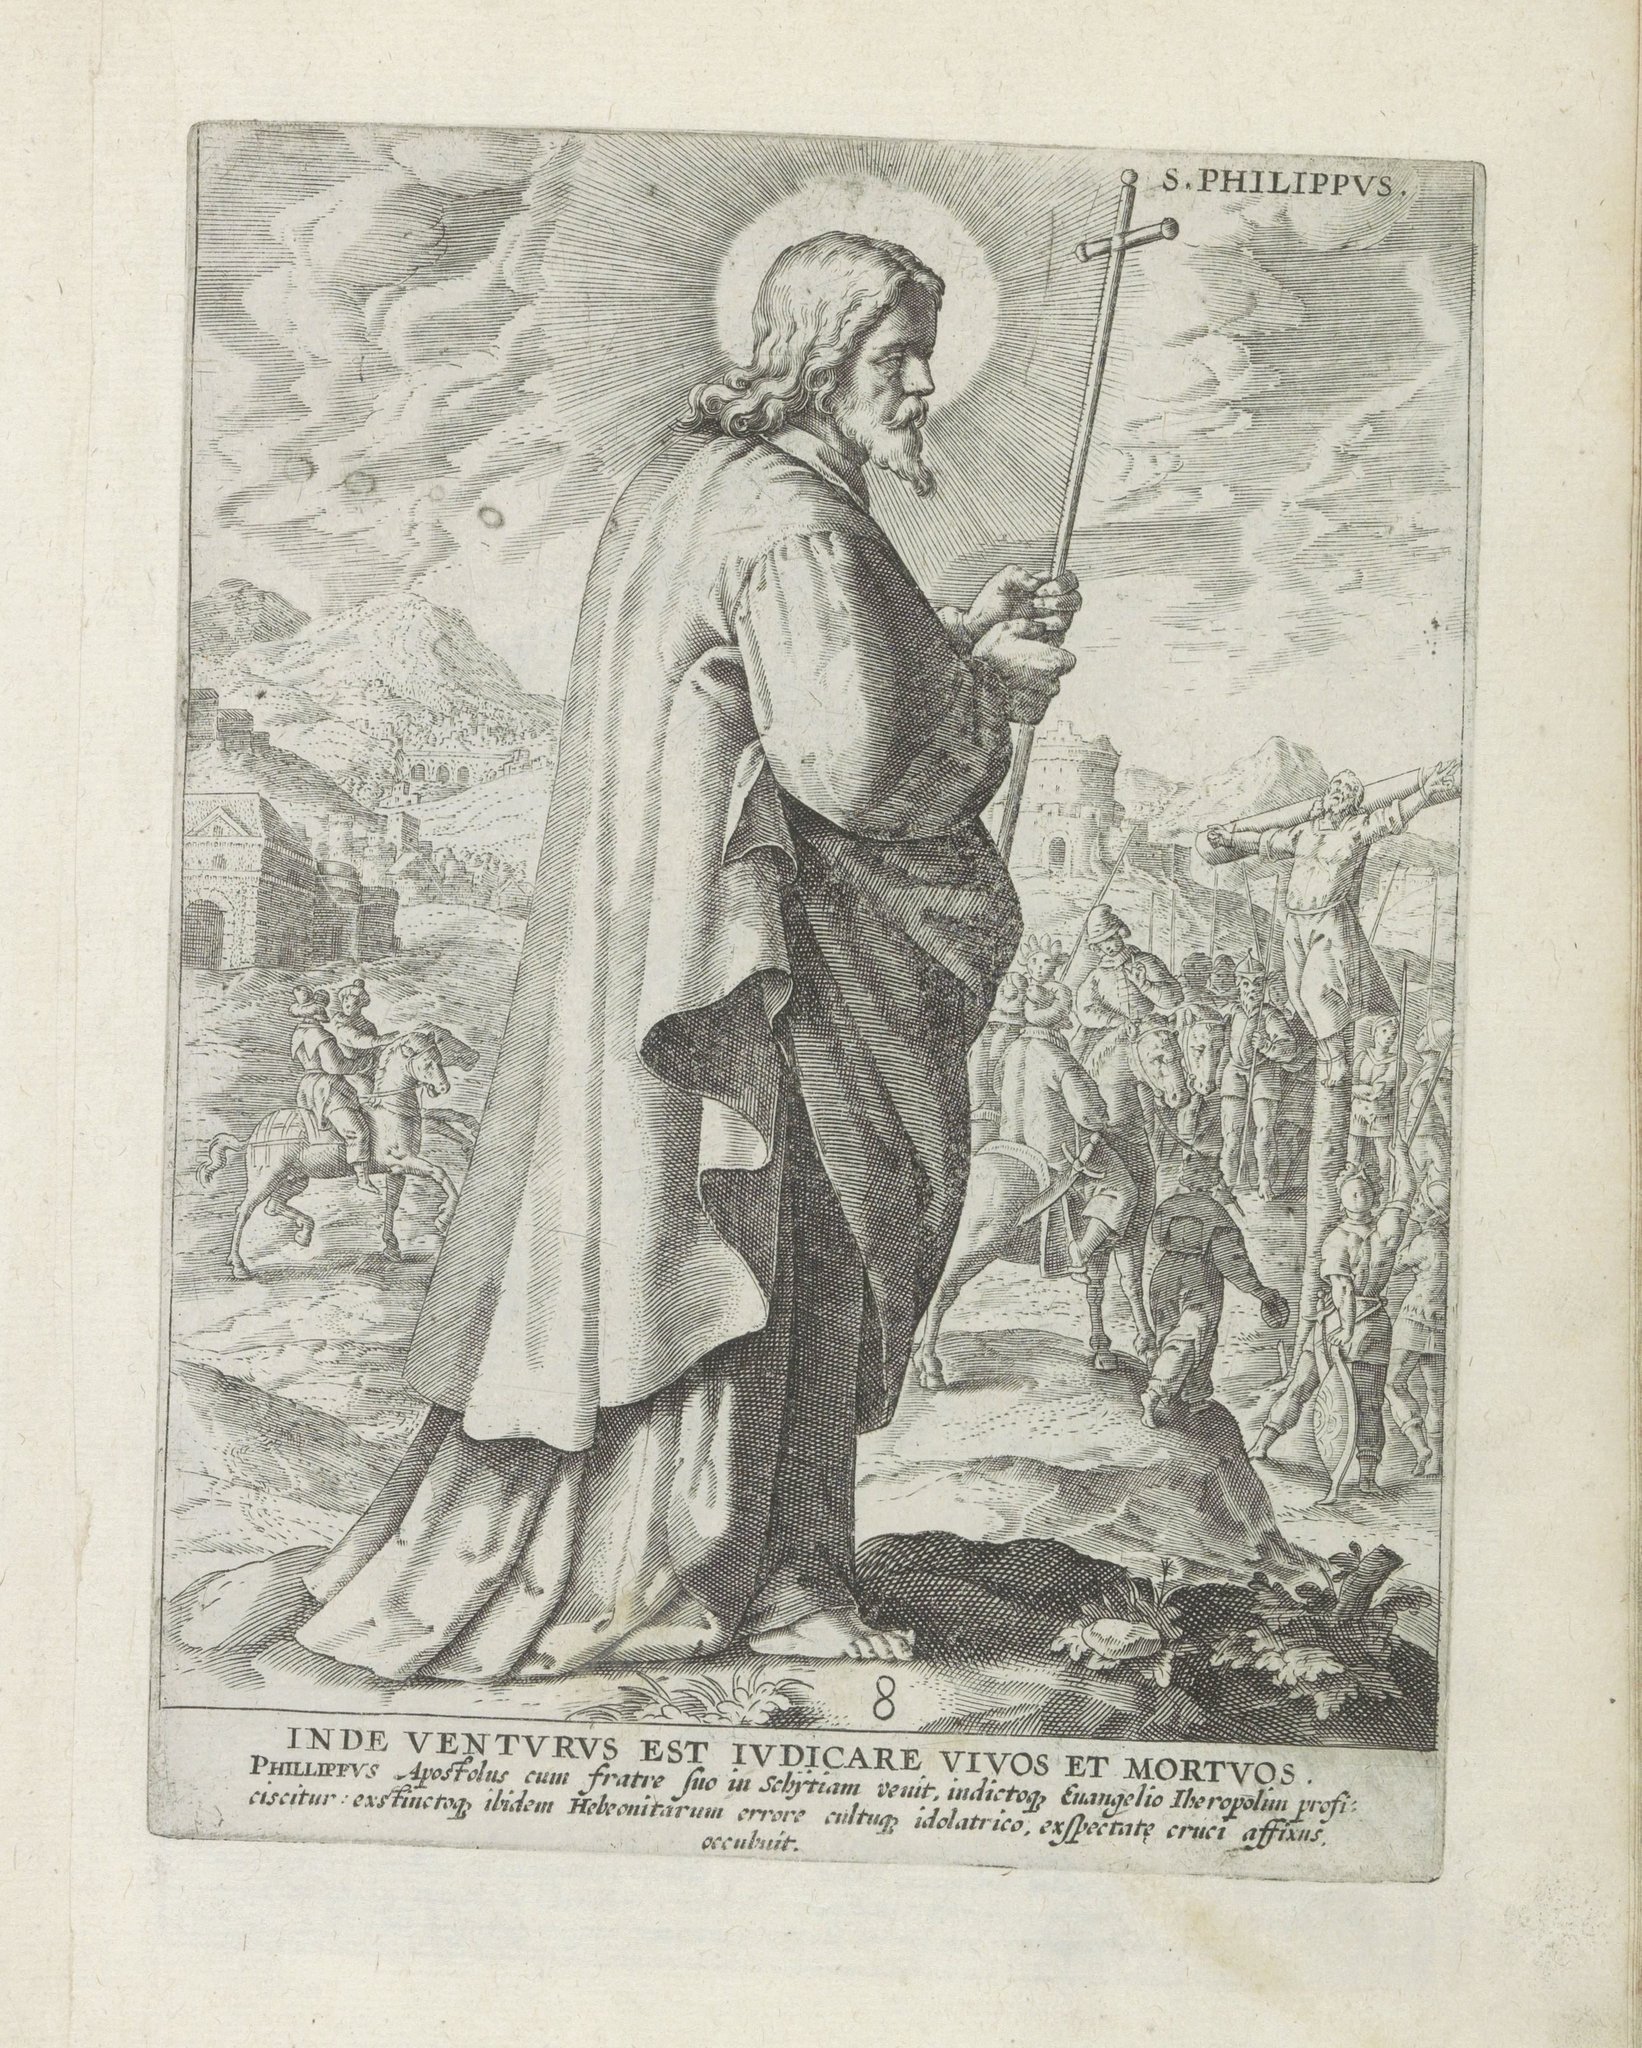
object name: album leaf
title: Thesaurus novi Testamenti elegantissimis iconibus expressus continens historias atque miracula doni nostri Iesu Christi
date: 1585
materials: paper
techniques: engraving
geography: antwerp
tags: the apostle philip; possible attributes: book, cross, dish with snake, lance, scroll, stone, sword, the apostle philip; possible attributes: book, cross, dish with snake, lance, scroll, stone, sword - martyrdom, suffering, misfortune, death of male saint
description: De apostel Filippus staande met een kruis in de handen. Rechts op de achtergrond zijn kruisiging. Onder de voorstelling een regel uit de apostolische geloofsbelijdenis en een drieregelige tekst over Filippus in het Latijn. Deze prent maakt deel uit van een album.